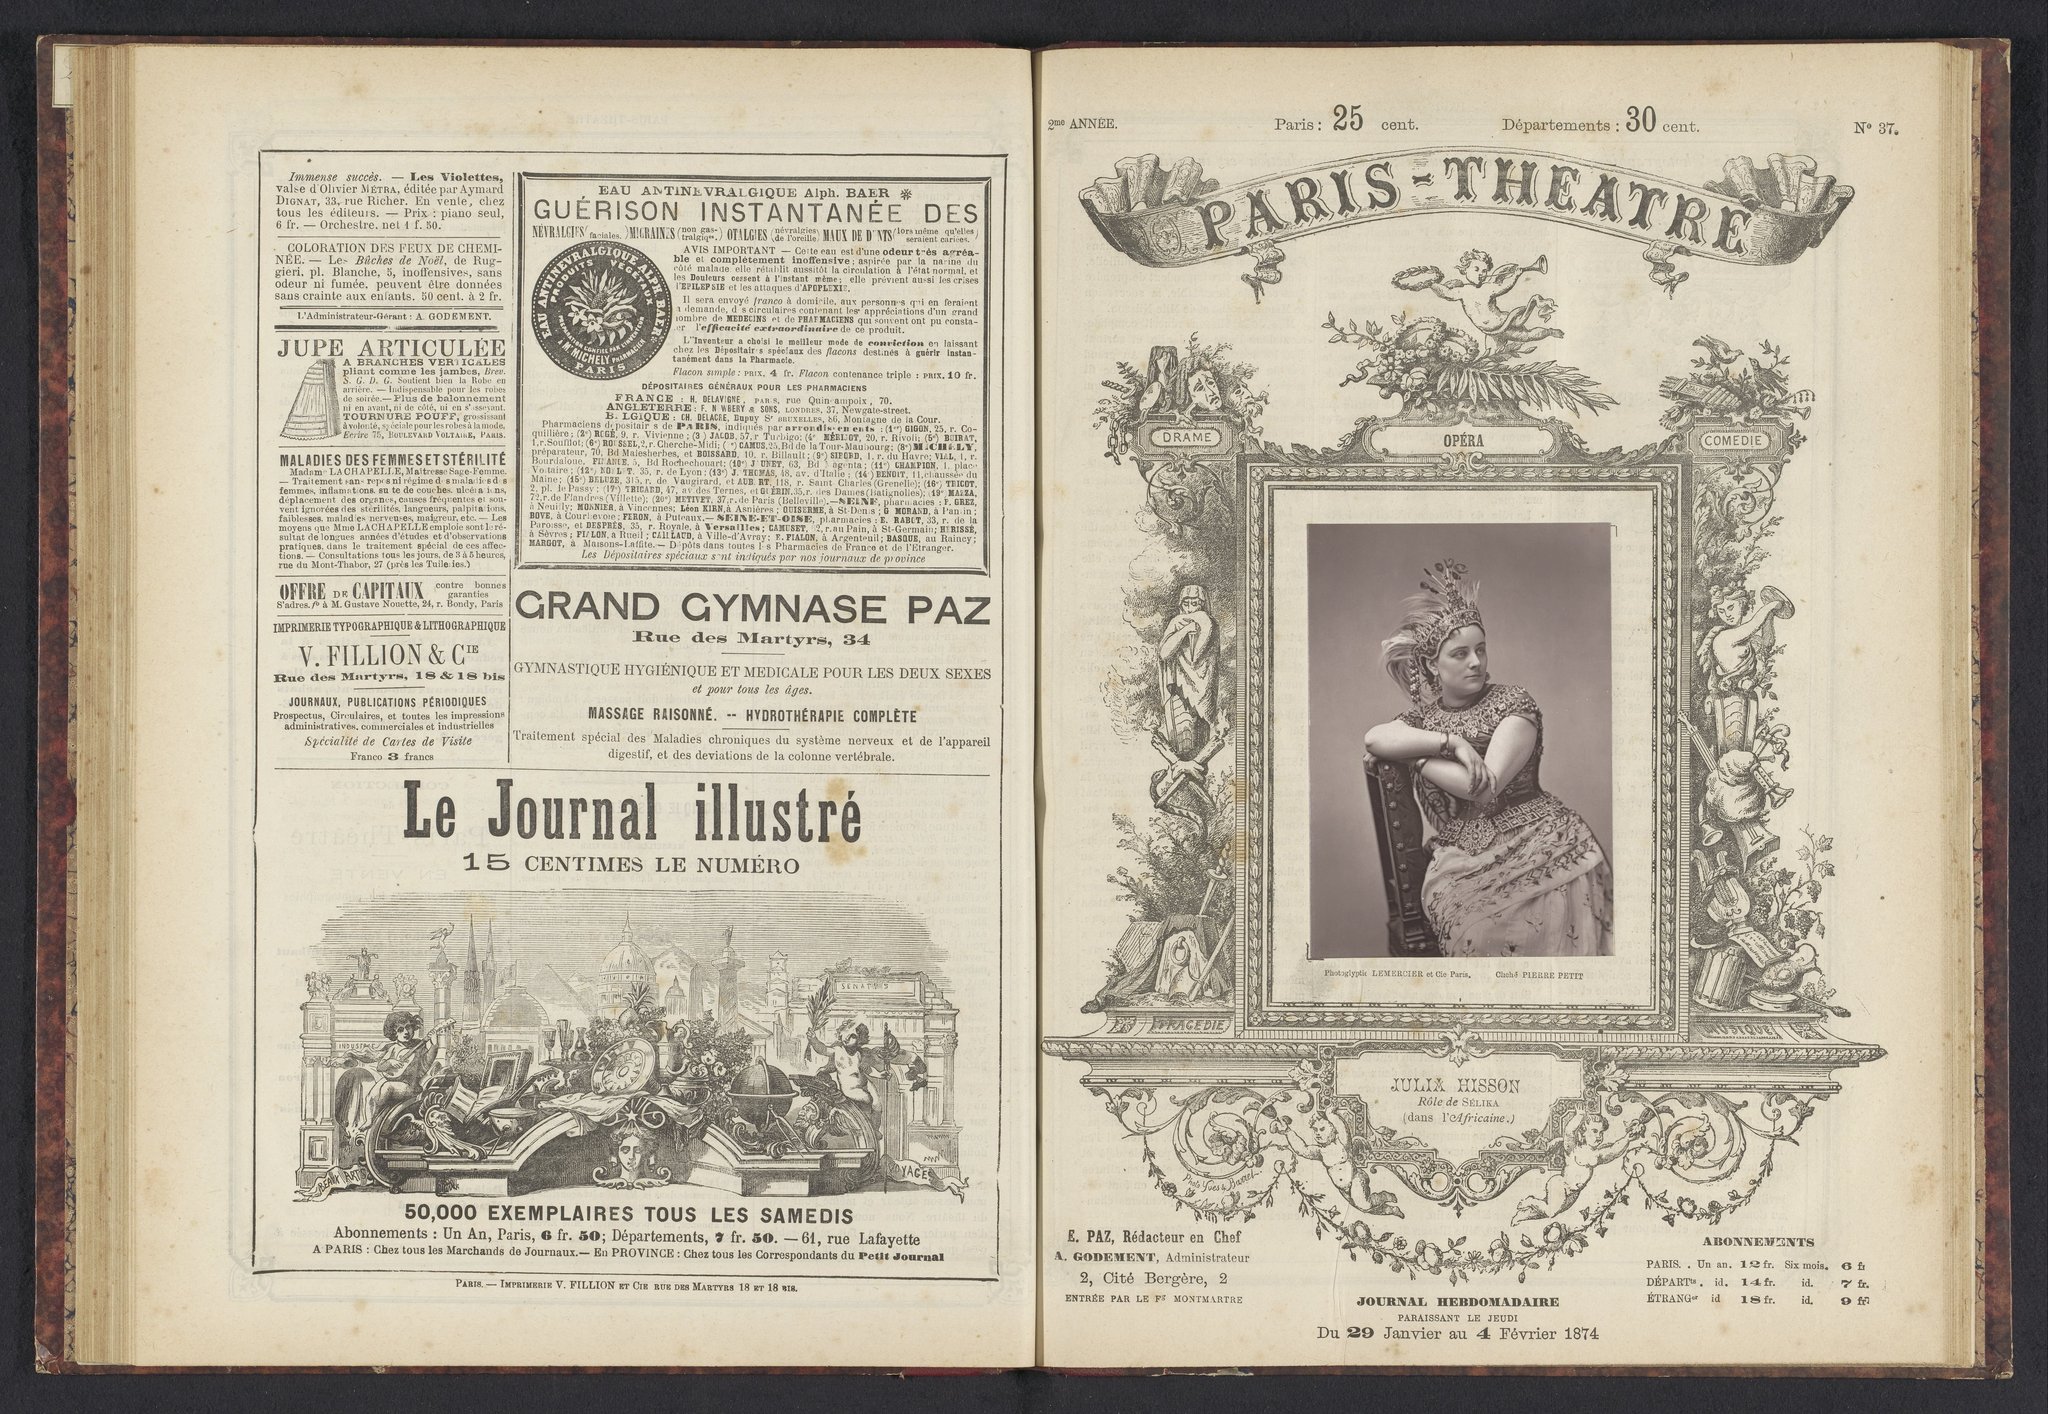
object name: page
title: Julia Hisson Rôle de Sélika (dans l'Africaine)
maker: pierre petit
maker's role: fotograaf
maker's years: 1832-1909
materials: paper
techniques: woodburytype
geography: france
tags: portrait of opera-singer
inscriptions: number: ‘No 37.’, inscription: ‘Journal hebdomadaire paraissant le Jeudi Du 29 Janvier au 4 Février 1874’